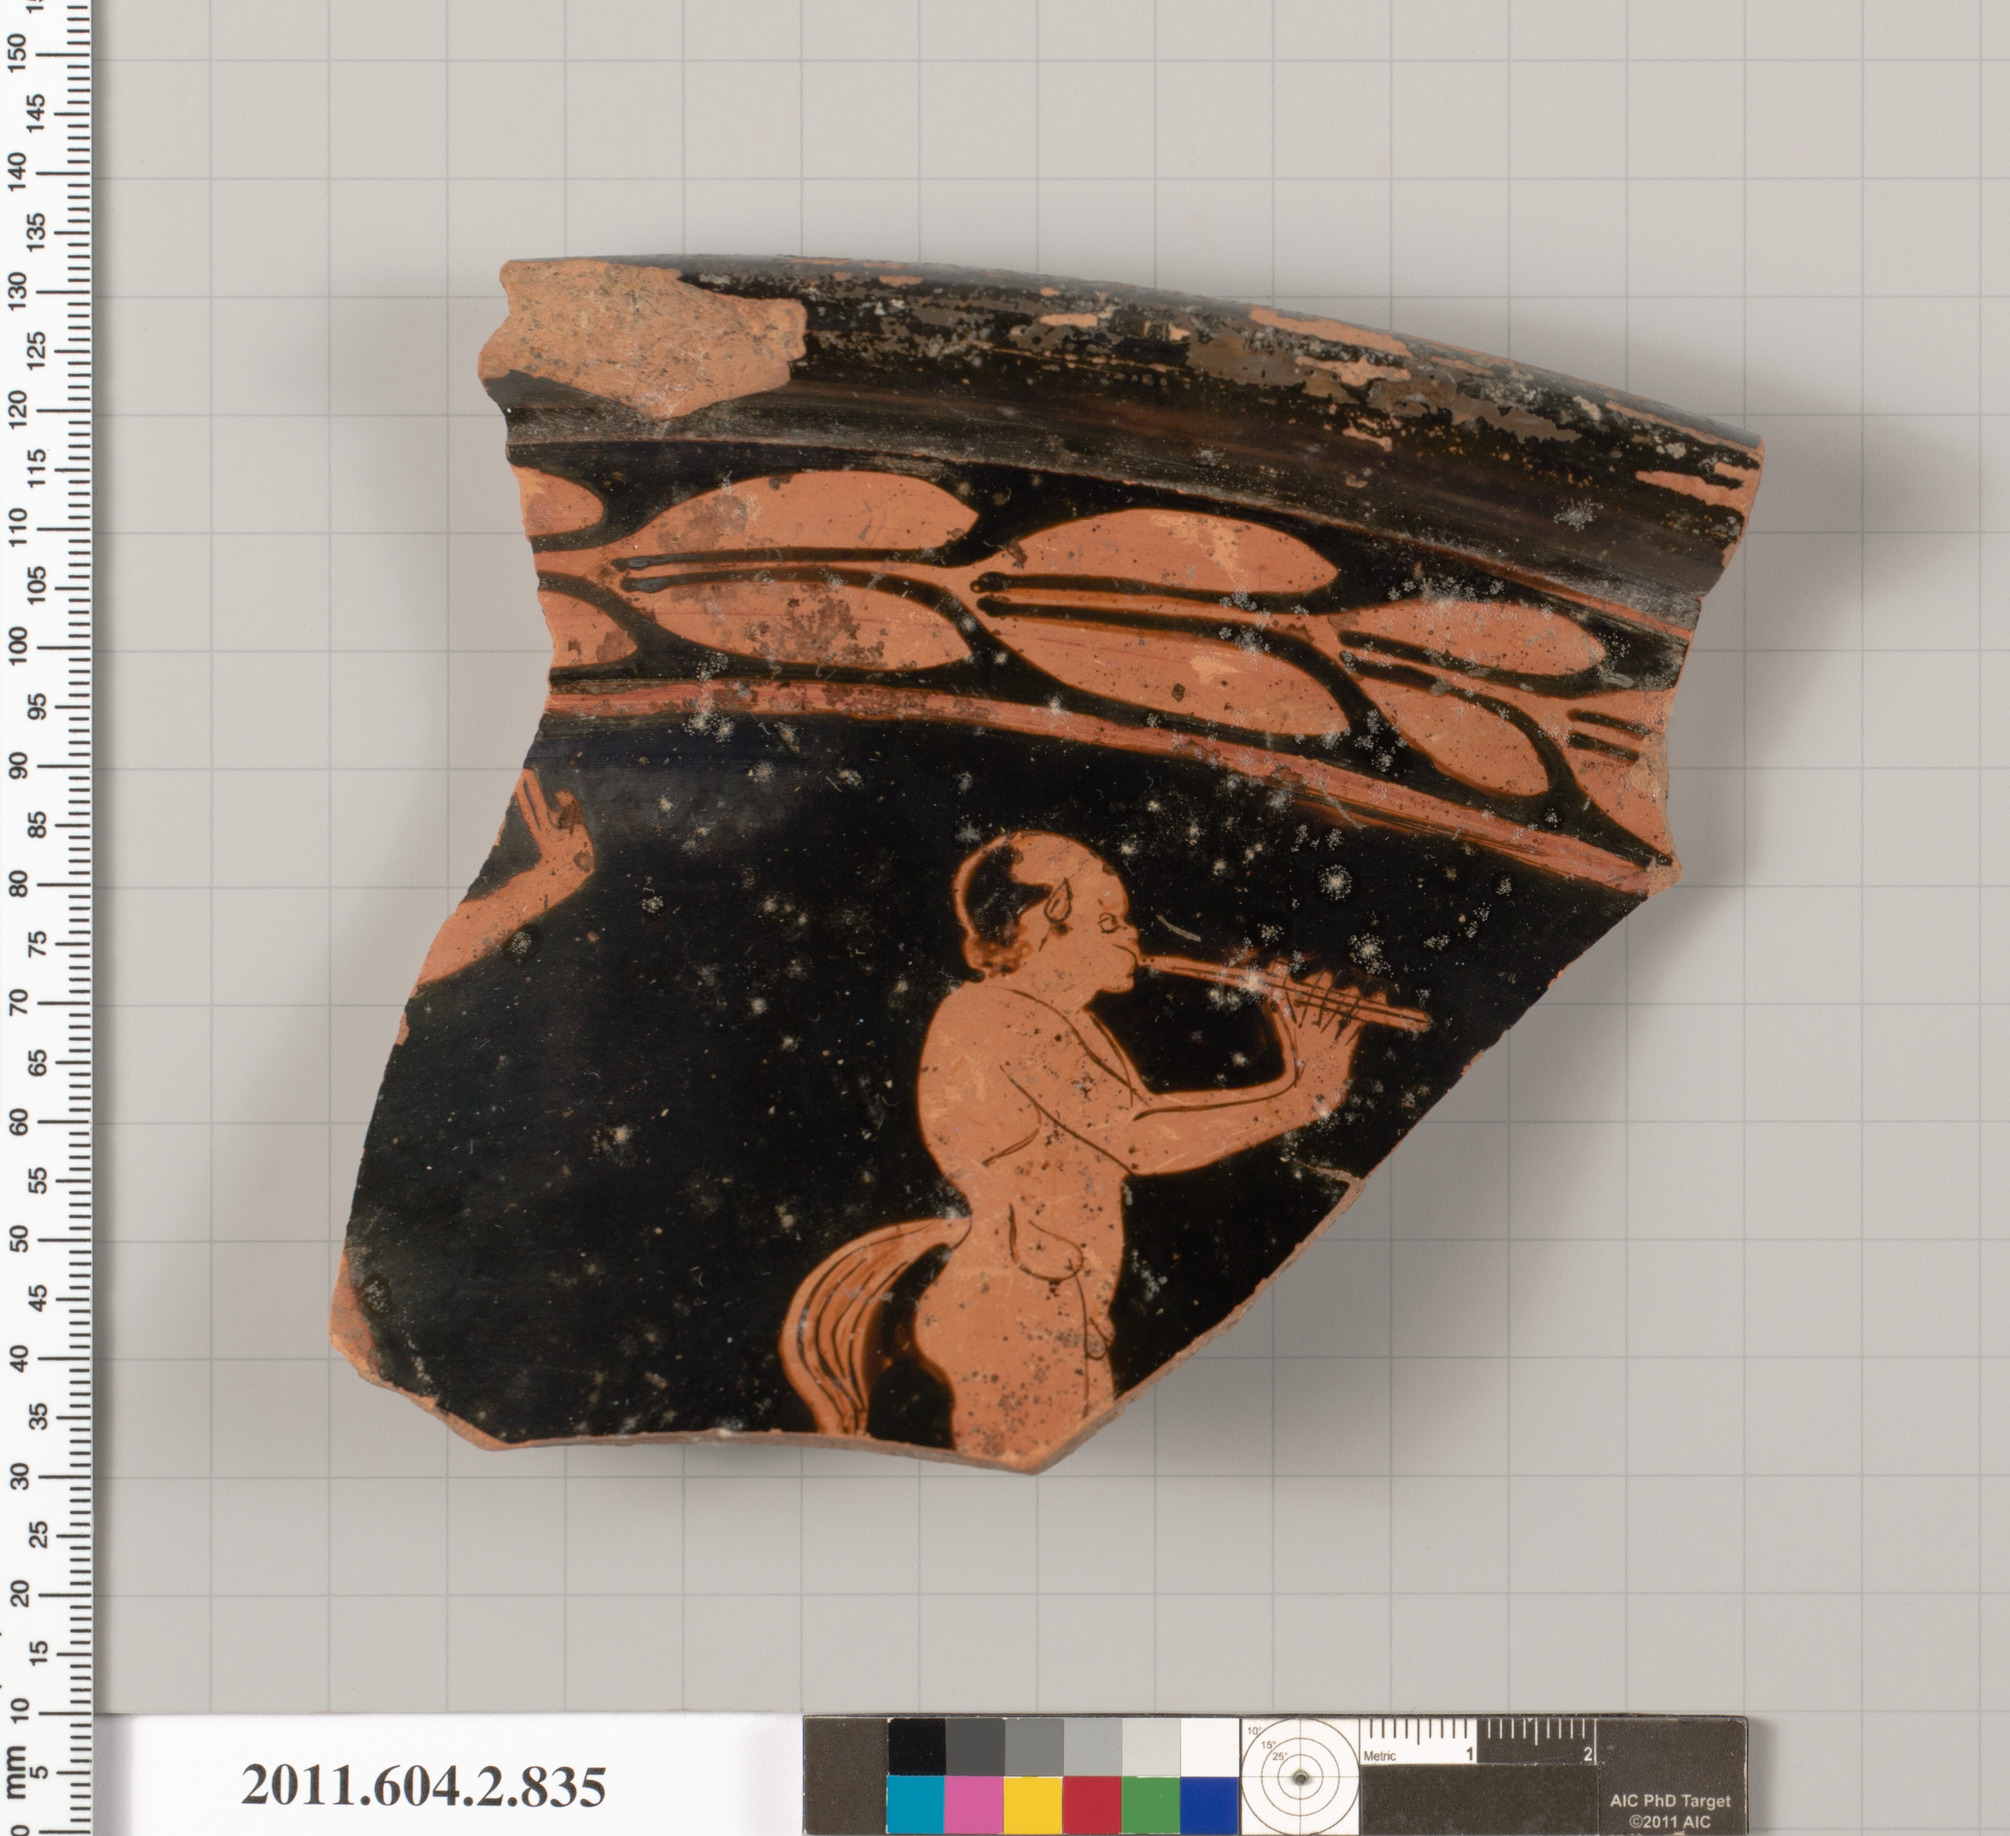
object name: bell krater fragment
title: Terracotta fragment of a bell-krater (bowl for mixing wine and water)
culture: greek, attic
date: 440 BCE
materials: terracotta